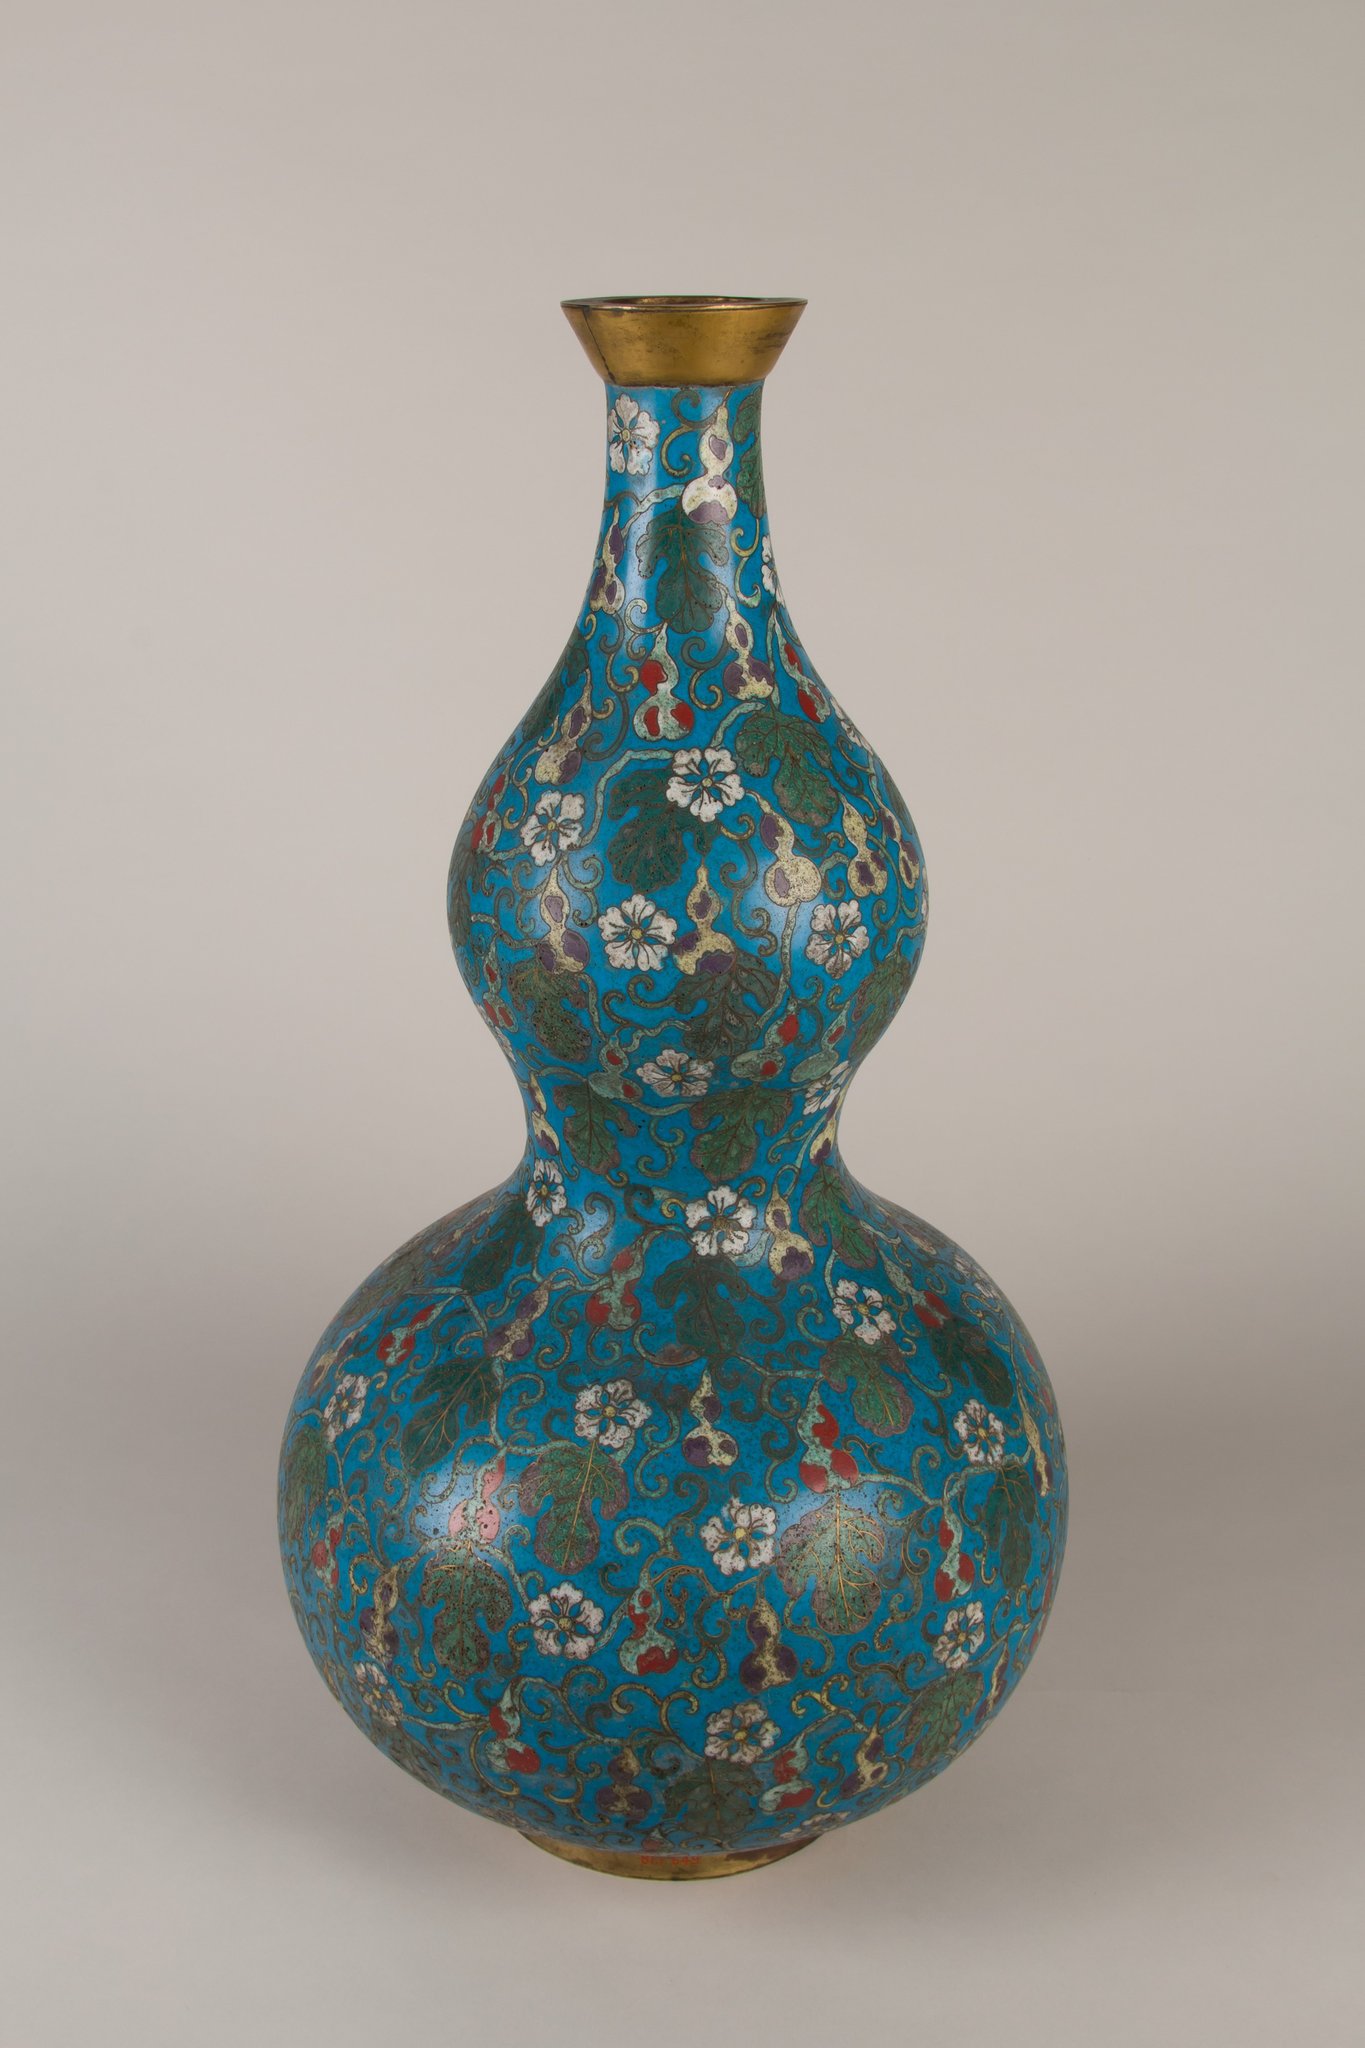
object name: vase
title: Vase (one of a pair)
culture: chinese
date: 1368-1644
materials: enamel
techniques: enamel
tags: flowers